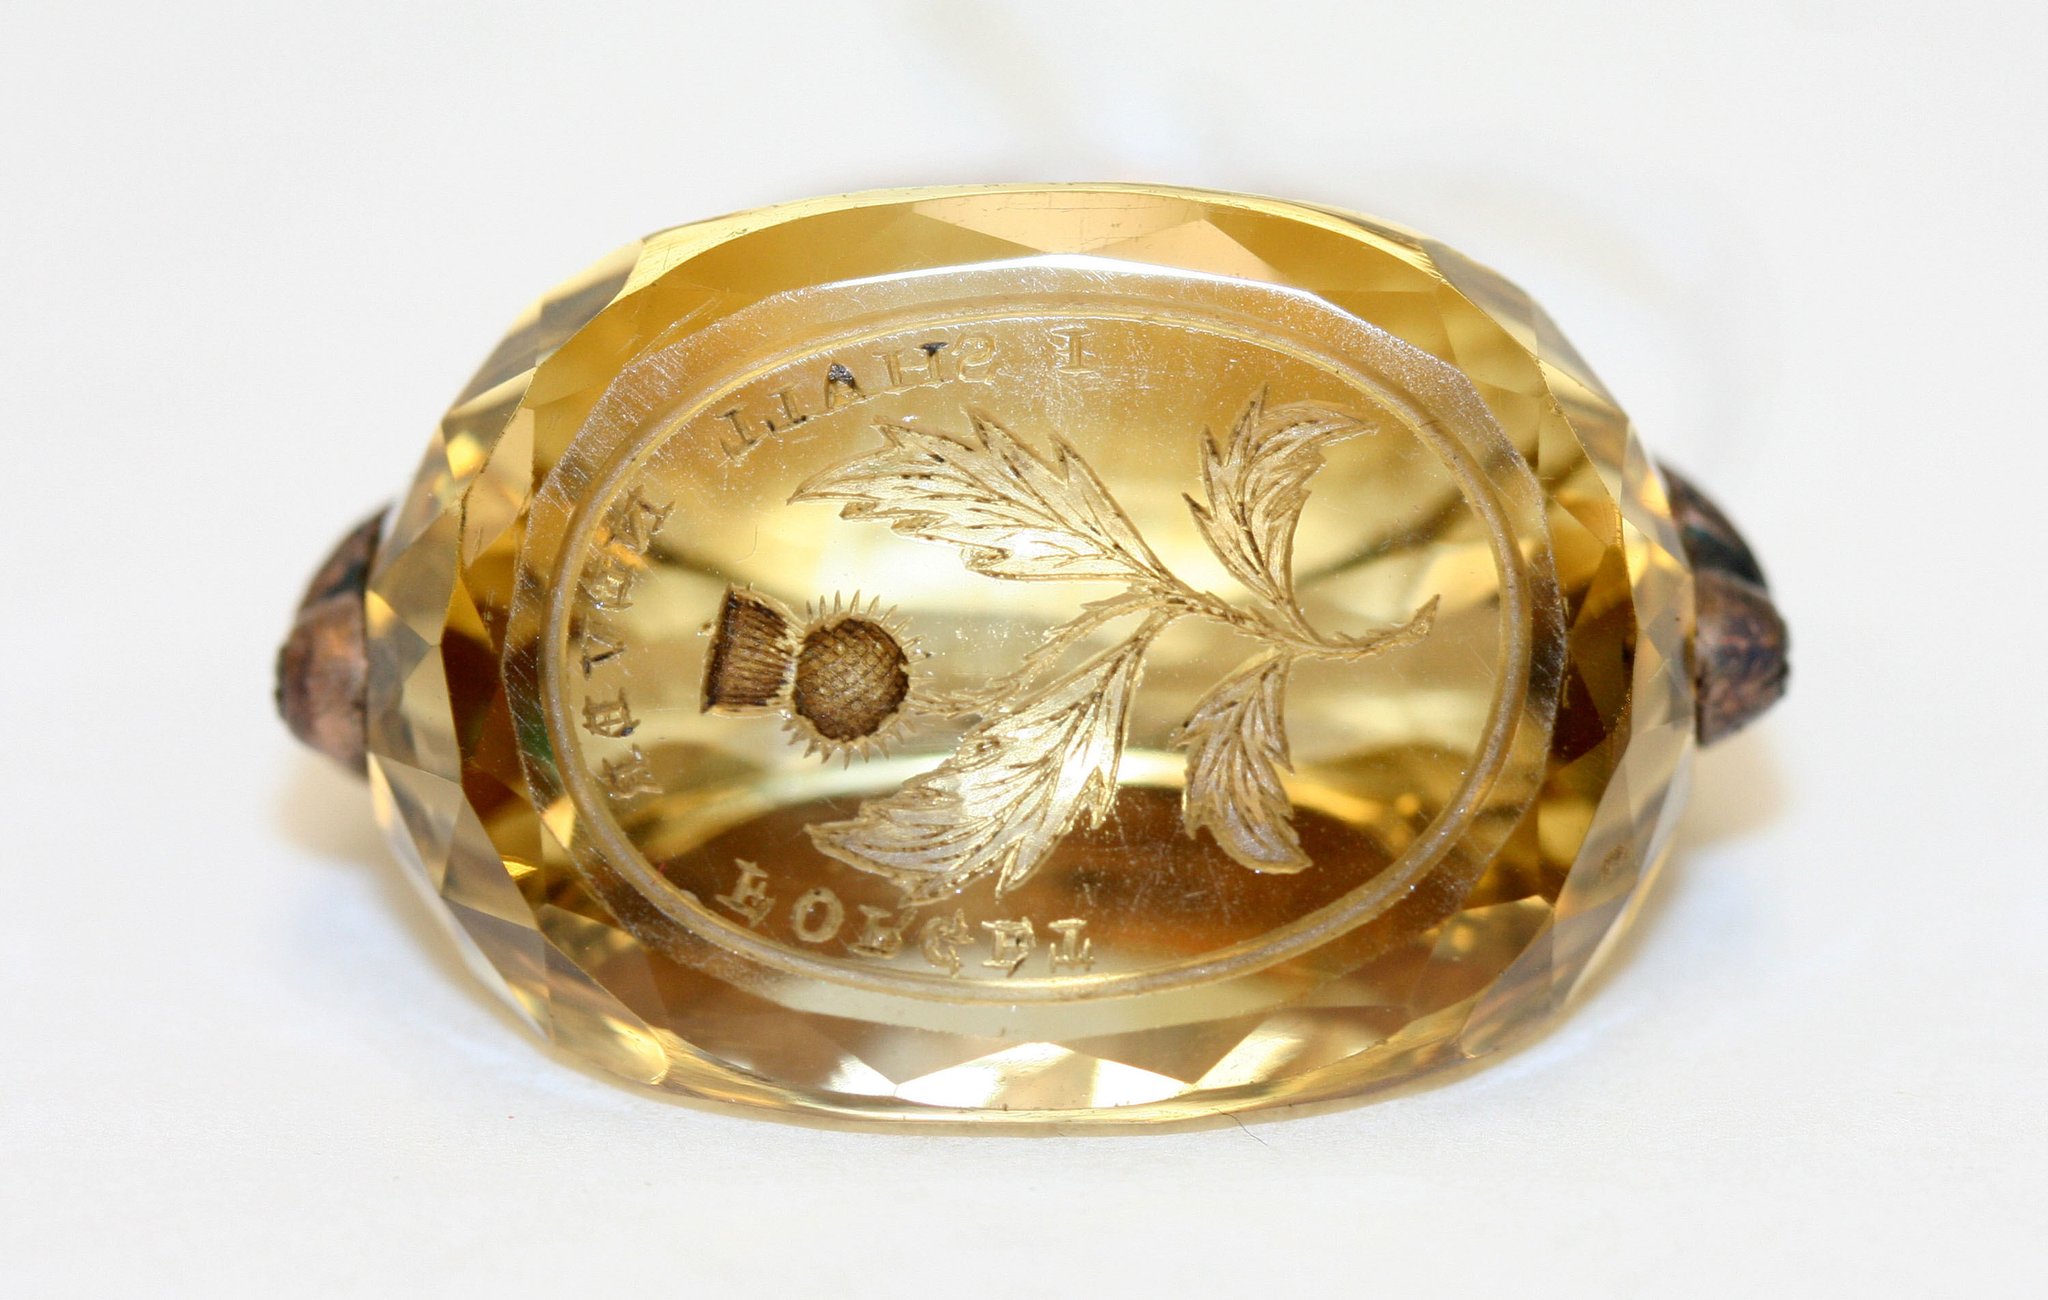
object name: seal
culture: british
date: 1820-1840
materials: gold, metal, quartz